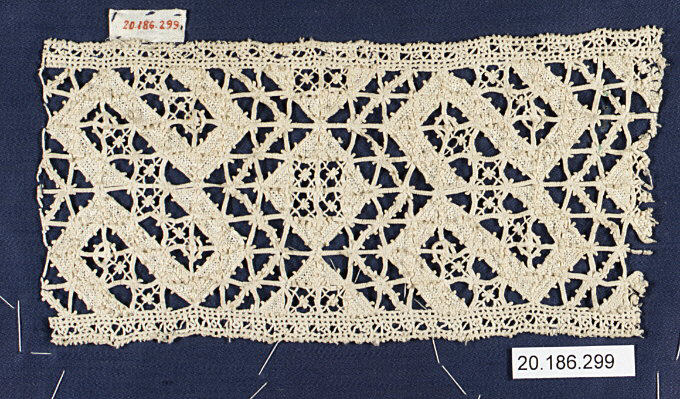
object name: strip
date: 1501-1600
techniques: embroidery